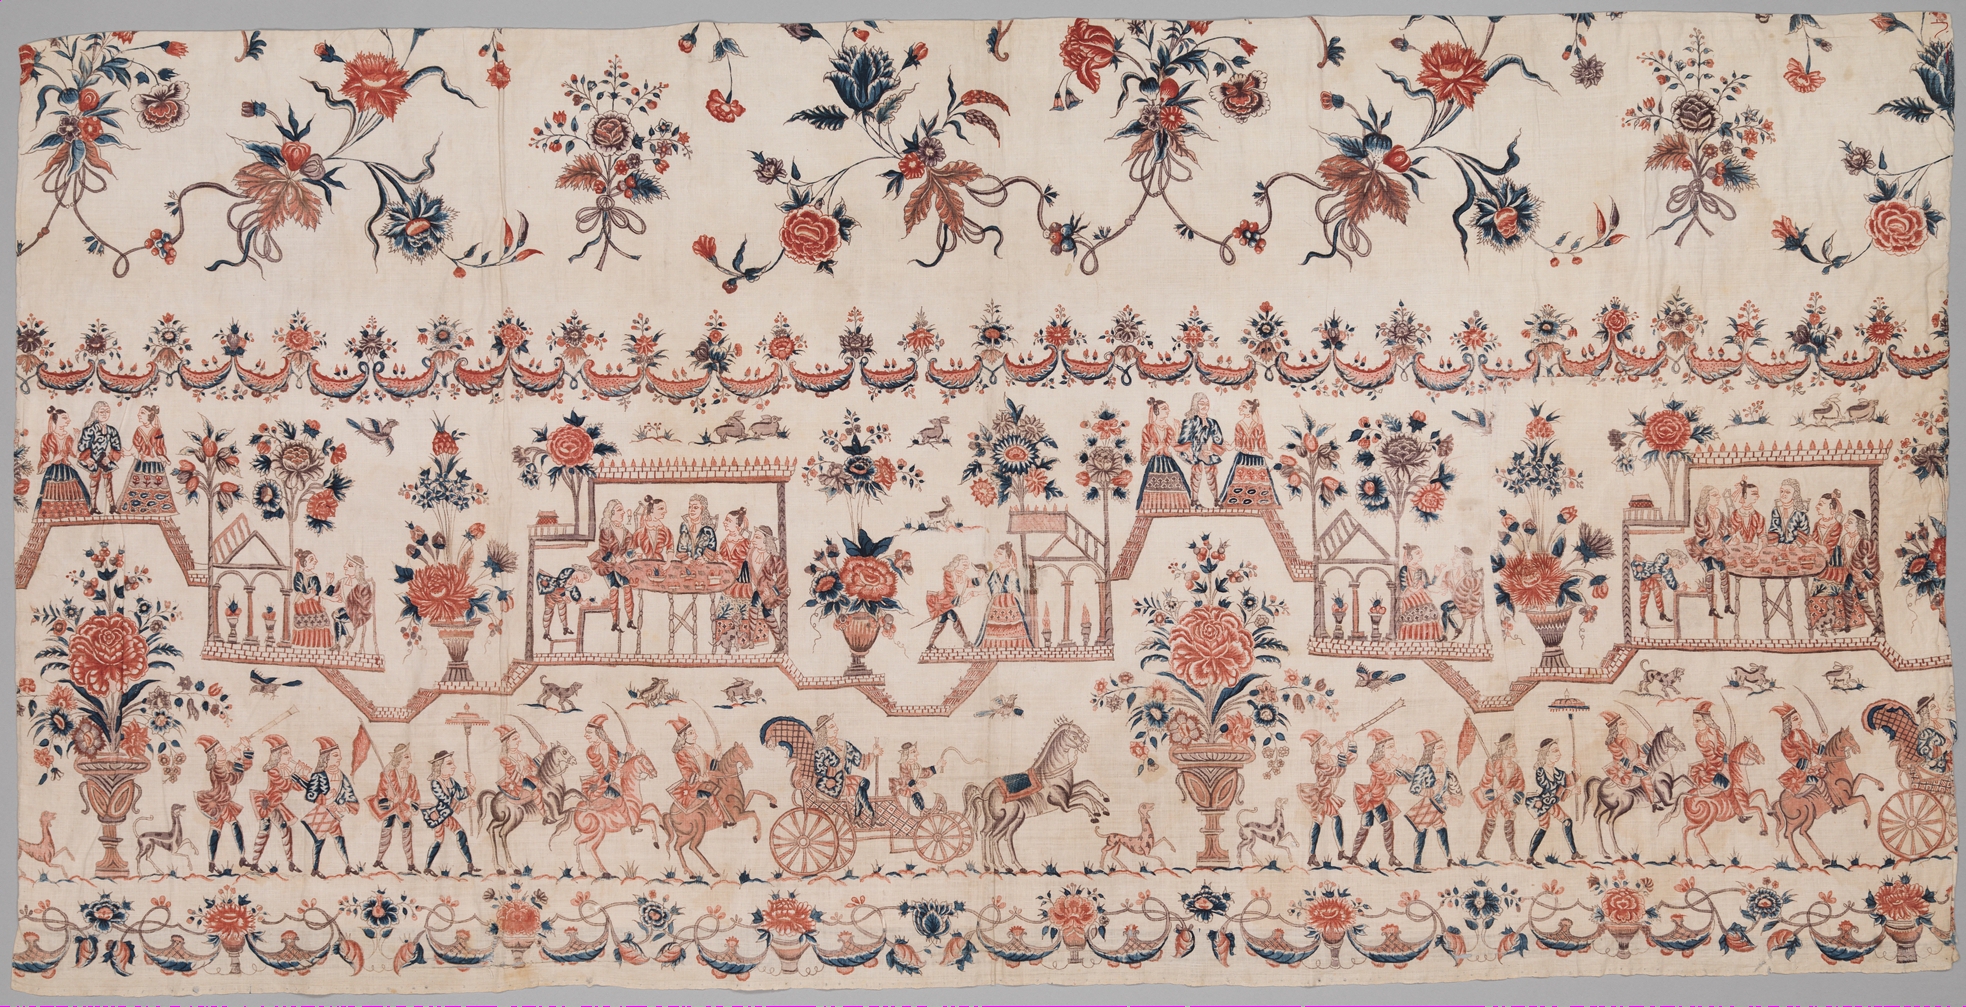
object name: panel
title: Petticoat panel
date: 1751-1775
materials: cotton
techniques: dyeing, painting, resist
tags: birds,men,women,dogs,horses,rabbits,flowers,carriages